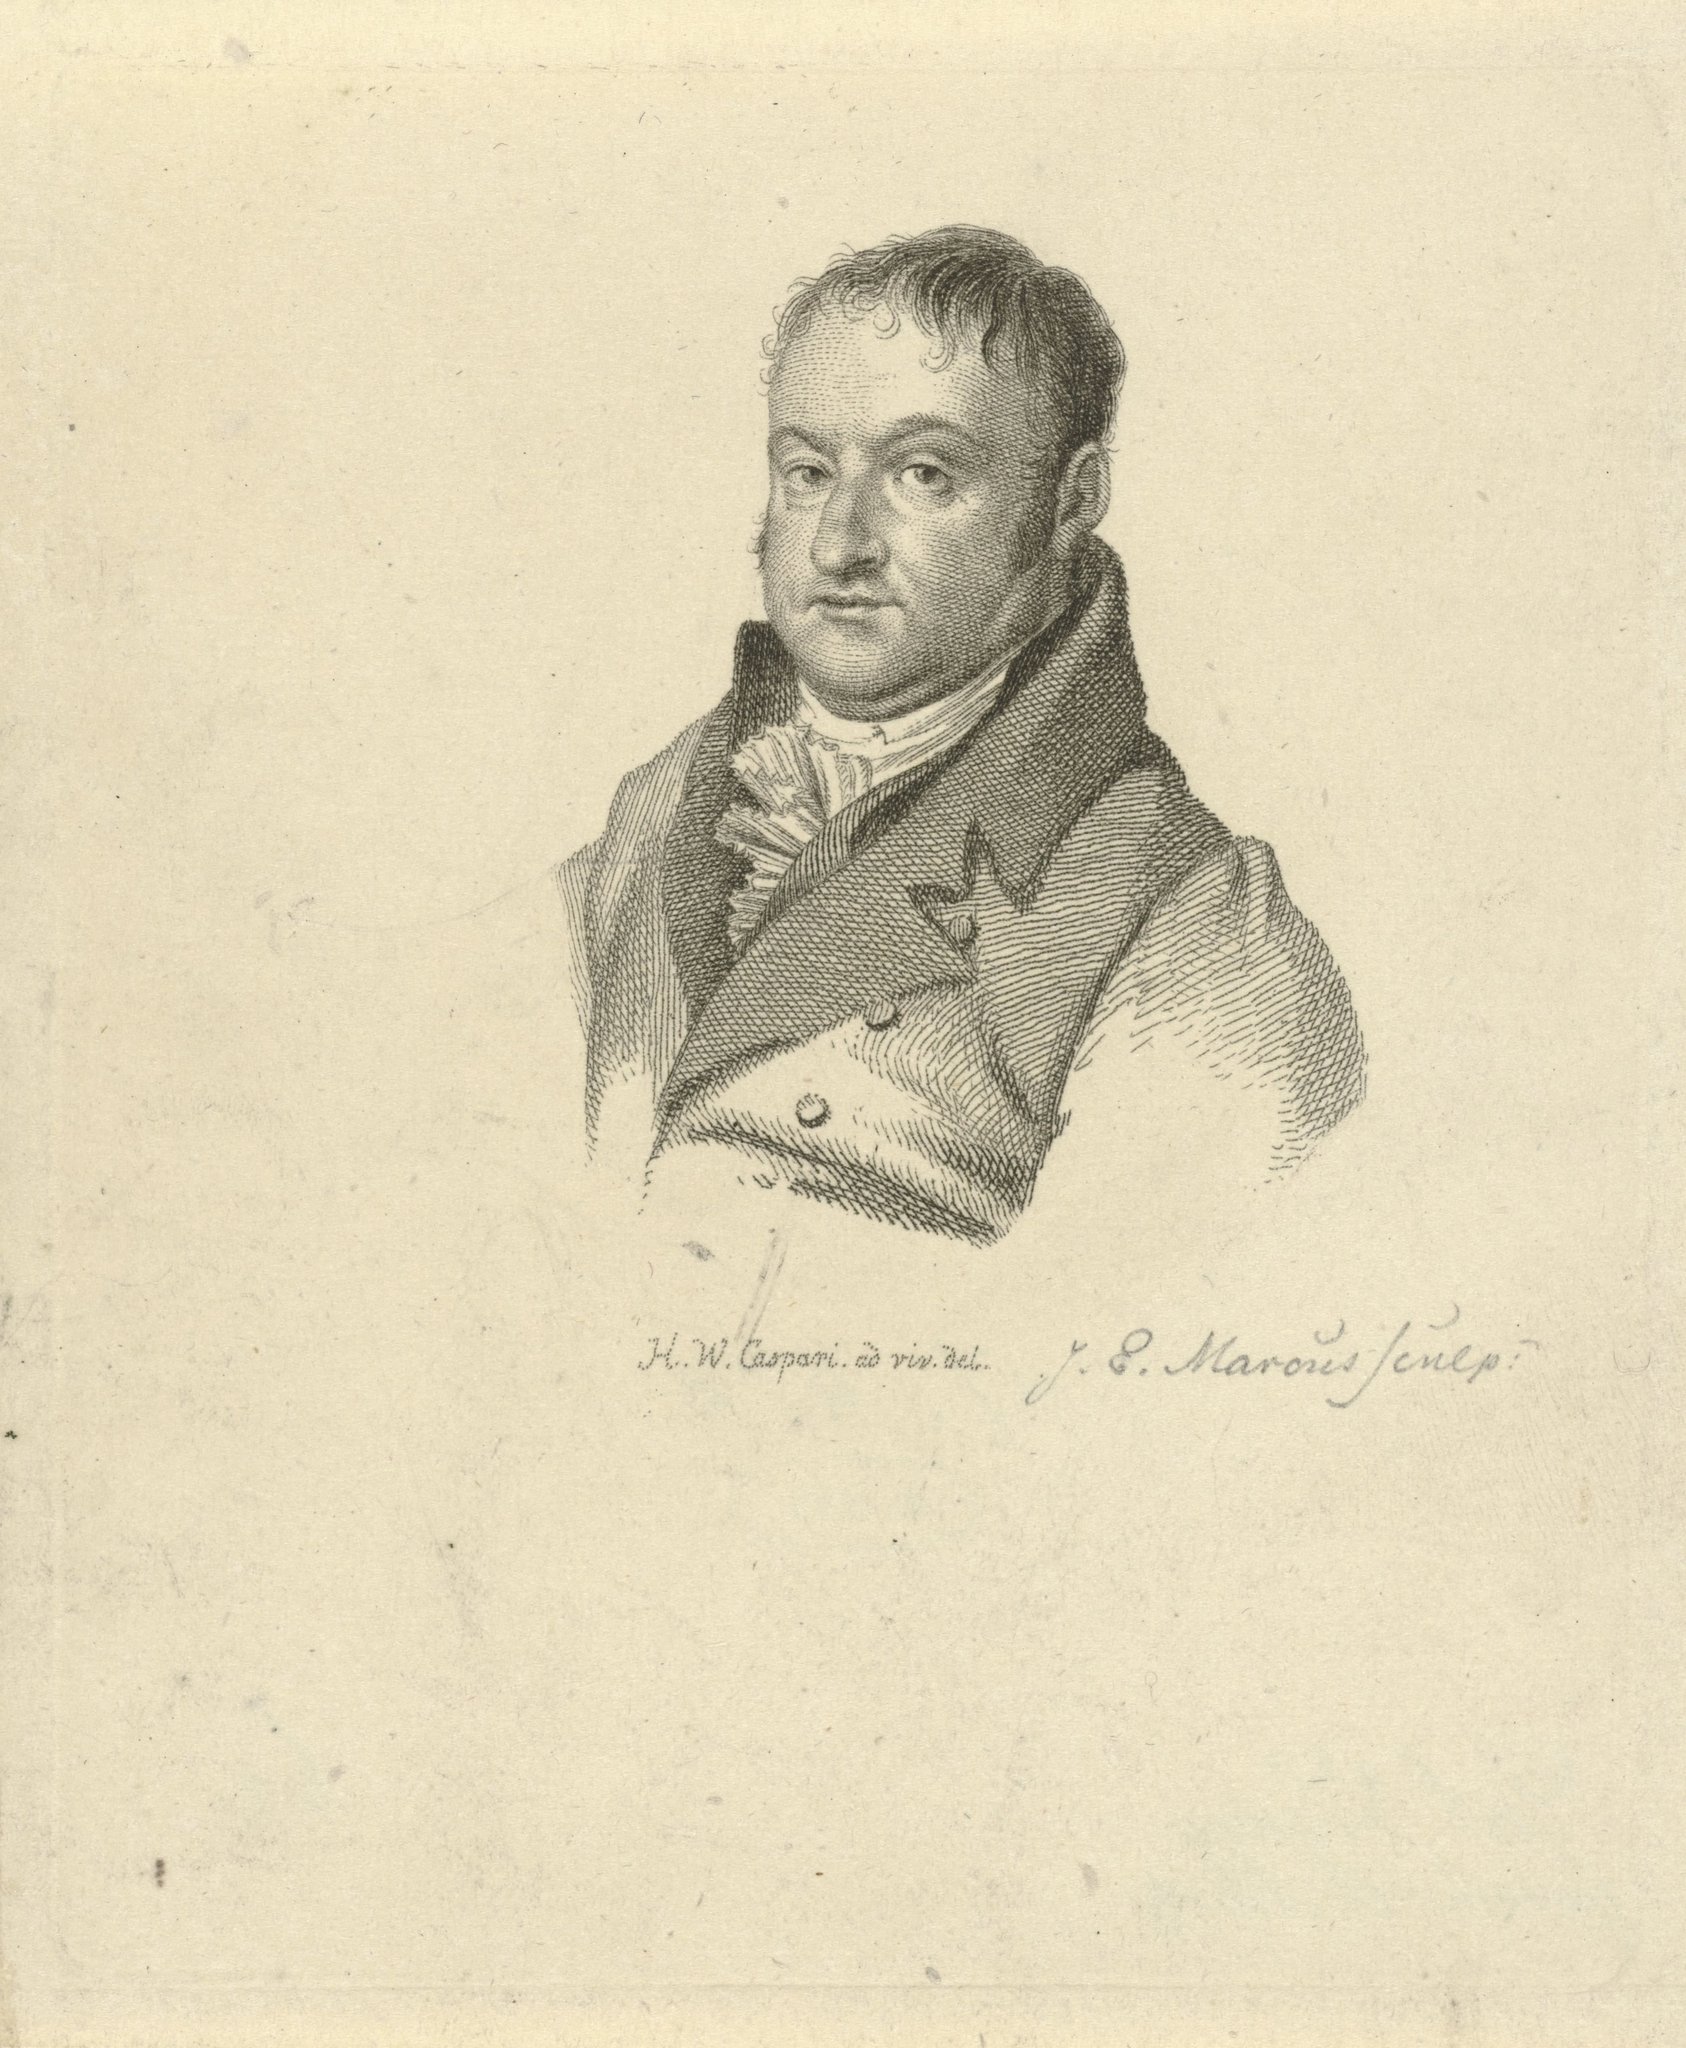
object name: print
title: Portret van Daniel Vrijdag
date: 1812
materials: paper, pencil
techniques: etching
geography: amsterdam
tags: the hague, amsterdam, print maker, draughtsman, daniël vrijdag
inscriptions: inscription: ‘Dl. Vrijdag/ Garveur te Amstr.’, collector's mark: Lugt 2228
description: Gehele prent gebruikt in: Jacob Ernst Marcus, Etudes gravées. Amsterdam: S. de Grebber, 1826.